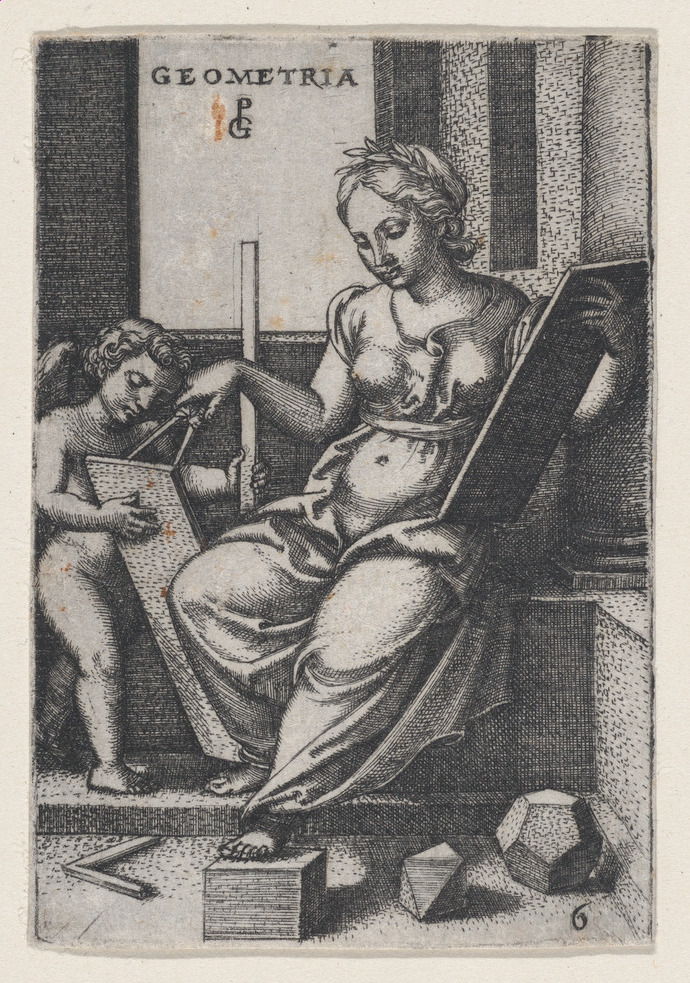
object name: print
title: Geometria, from "The Liberal Arts"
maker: georg pencz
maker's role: artist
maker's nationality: german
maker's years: 1500-1550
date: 1536-1546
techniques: engraving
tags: boys,women,geometry